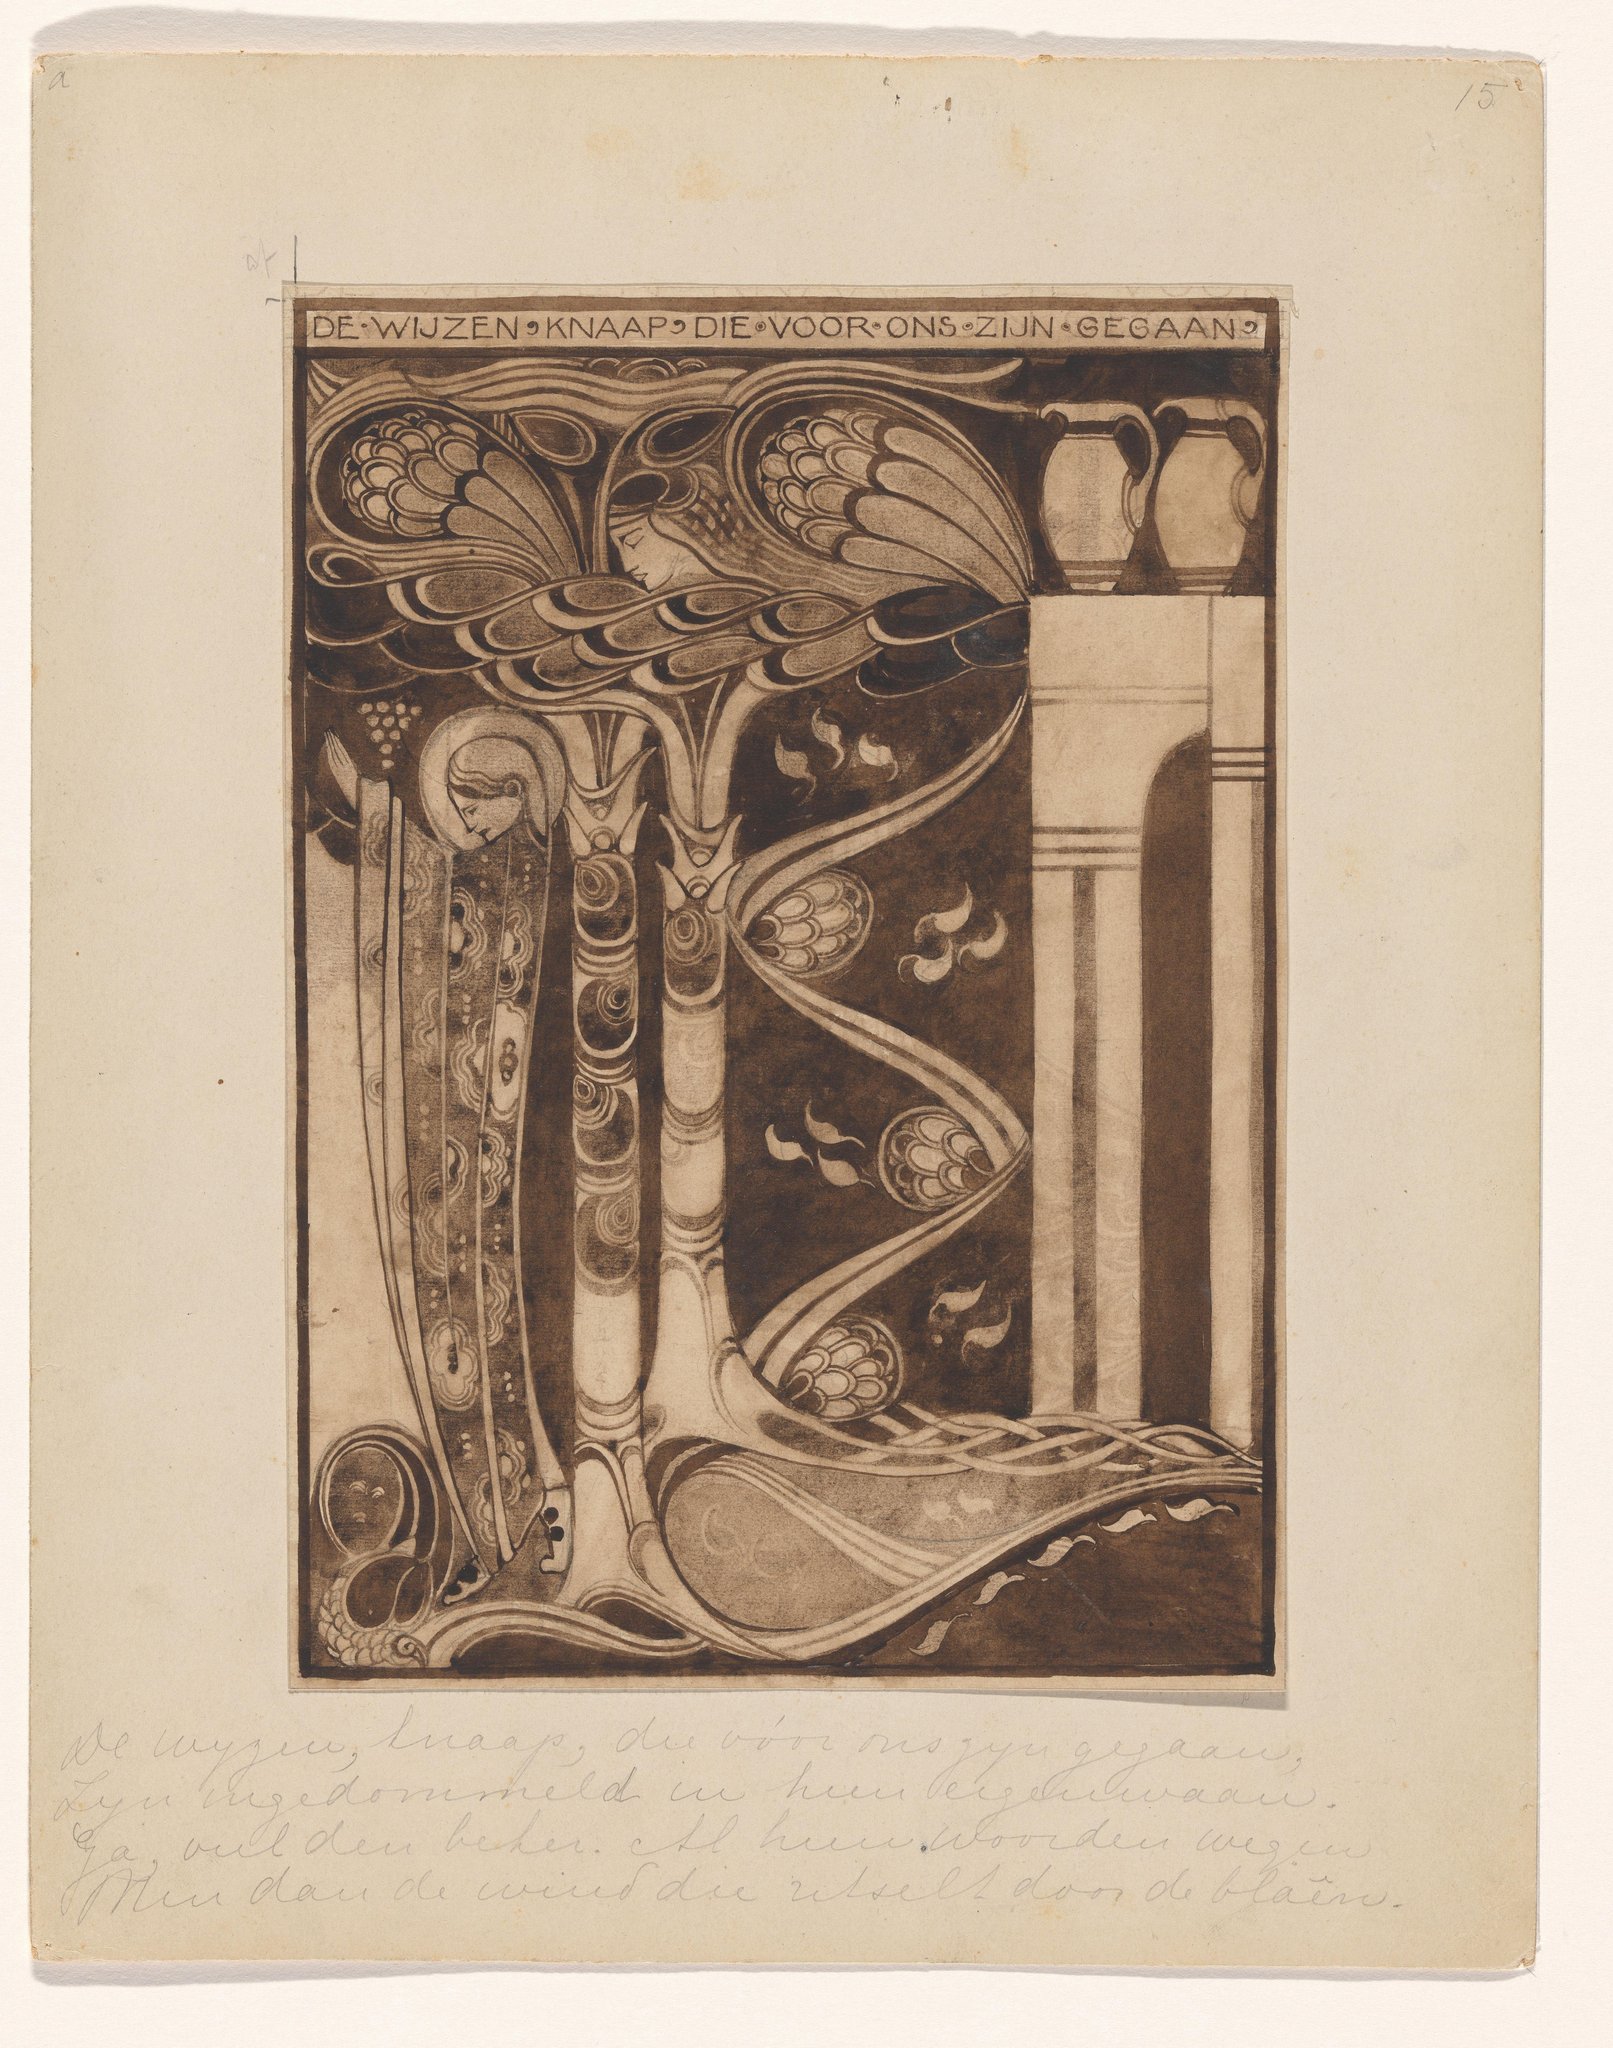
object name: drawing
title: De wijzen, knaap, die voor ons zijn gegaan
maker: willem arondéus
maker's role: draughtsman, print maker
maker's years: 1894-1943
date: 1914-1920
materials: cardboard, ink, paper, pencil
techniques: brush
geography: netherlands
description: Tekening naar de Rubaiyat van Omar Khayyam.